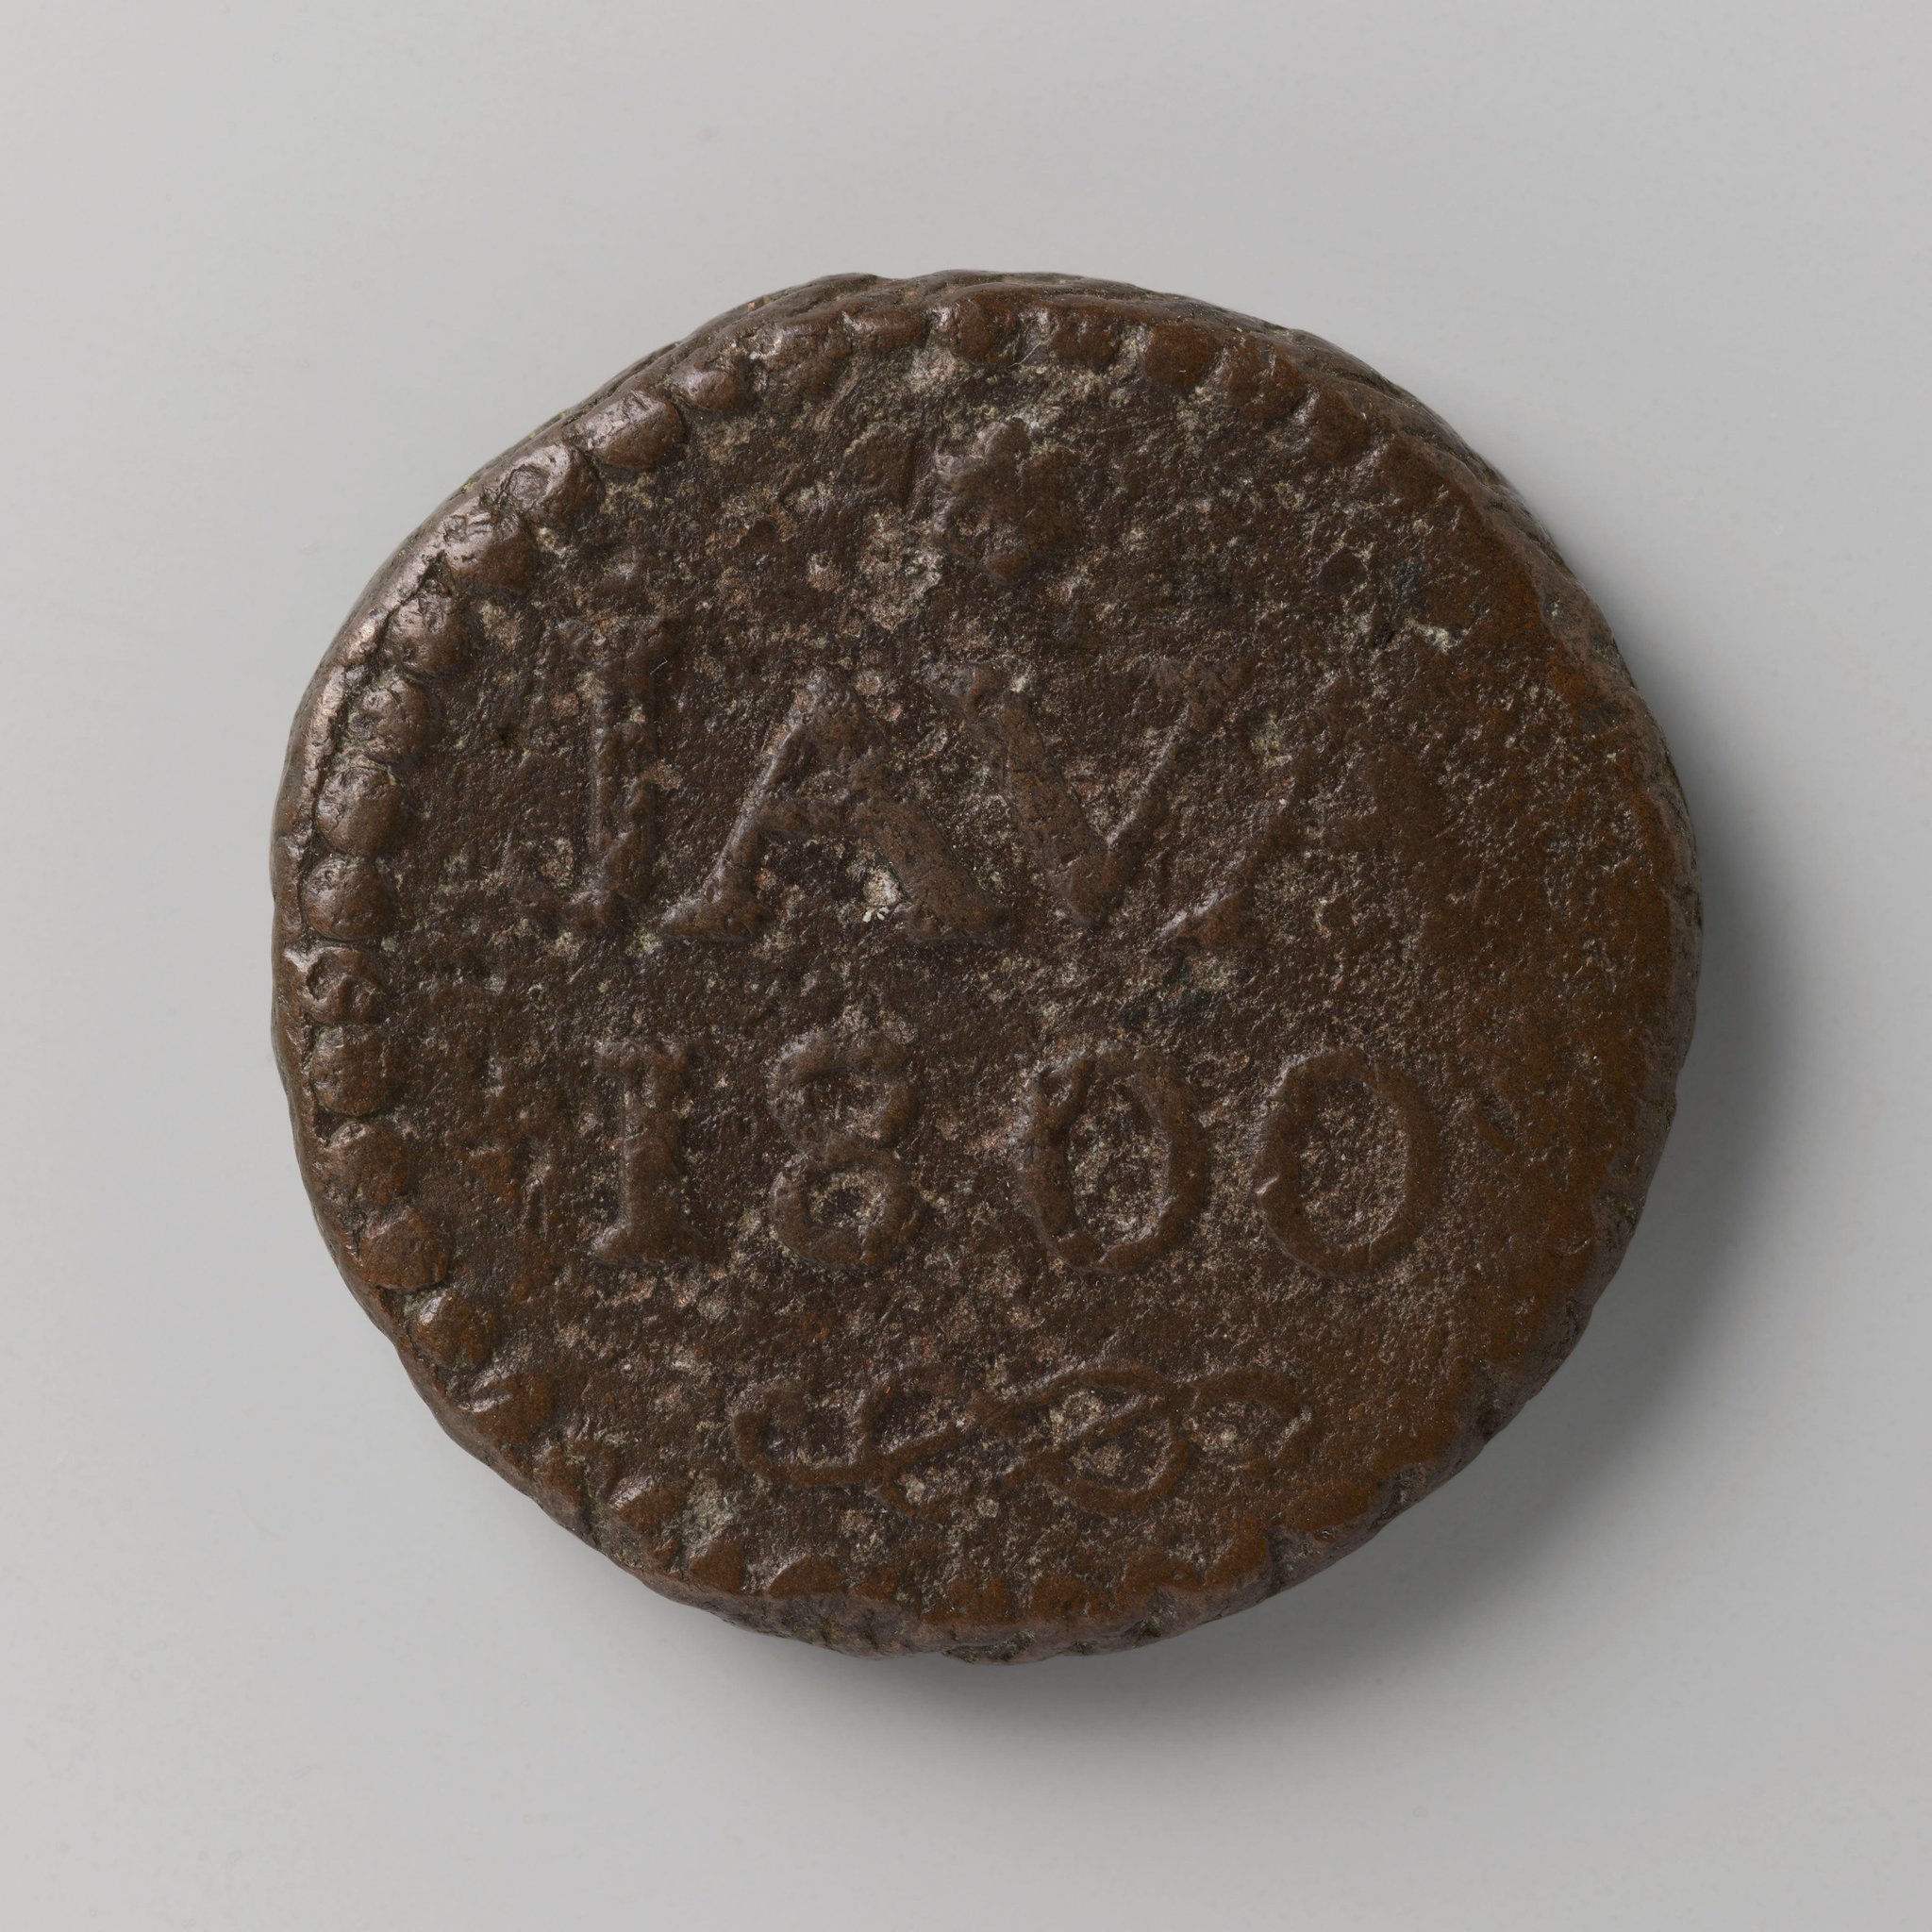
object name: coin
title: Nederlands Indië, stuiver noodmunt,1800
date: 1800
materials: bronze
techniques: striking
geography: batavia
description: Bronzen noodmunt. Voorzijde: opschrift, JAVA, waarboven muntteken en waaronder jaartal. Daaronder touwstrik. Keerzijde: waarde-aanduiding I St., waarboven muntteken en waaronder touwstrik. Kabelrand.